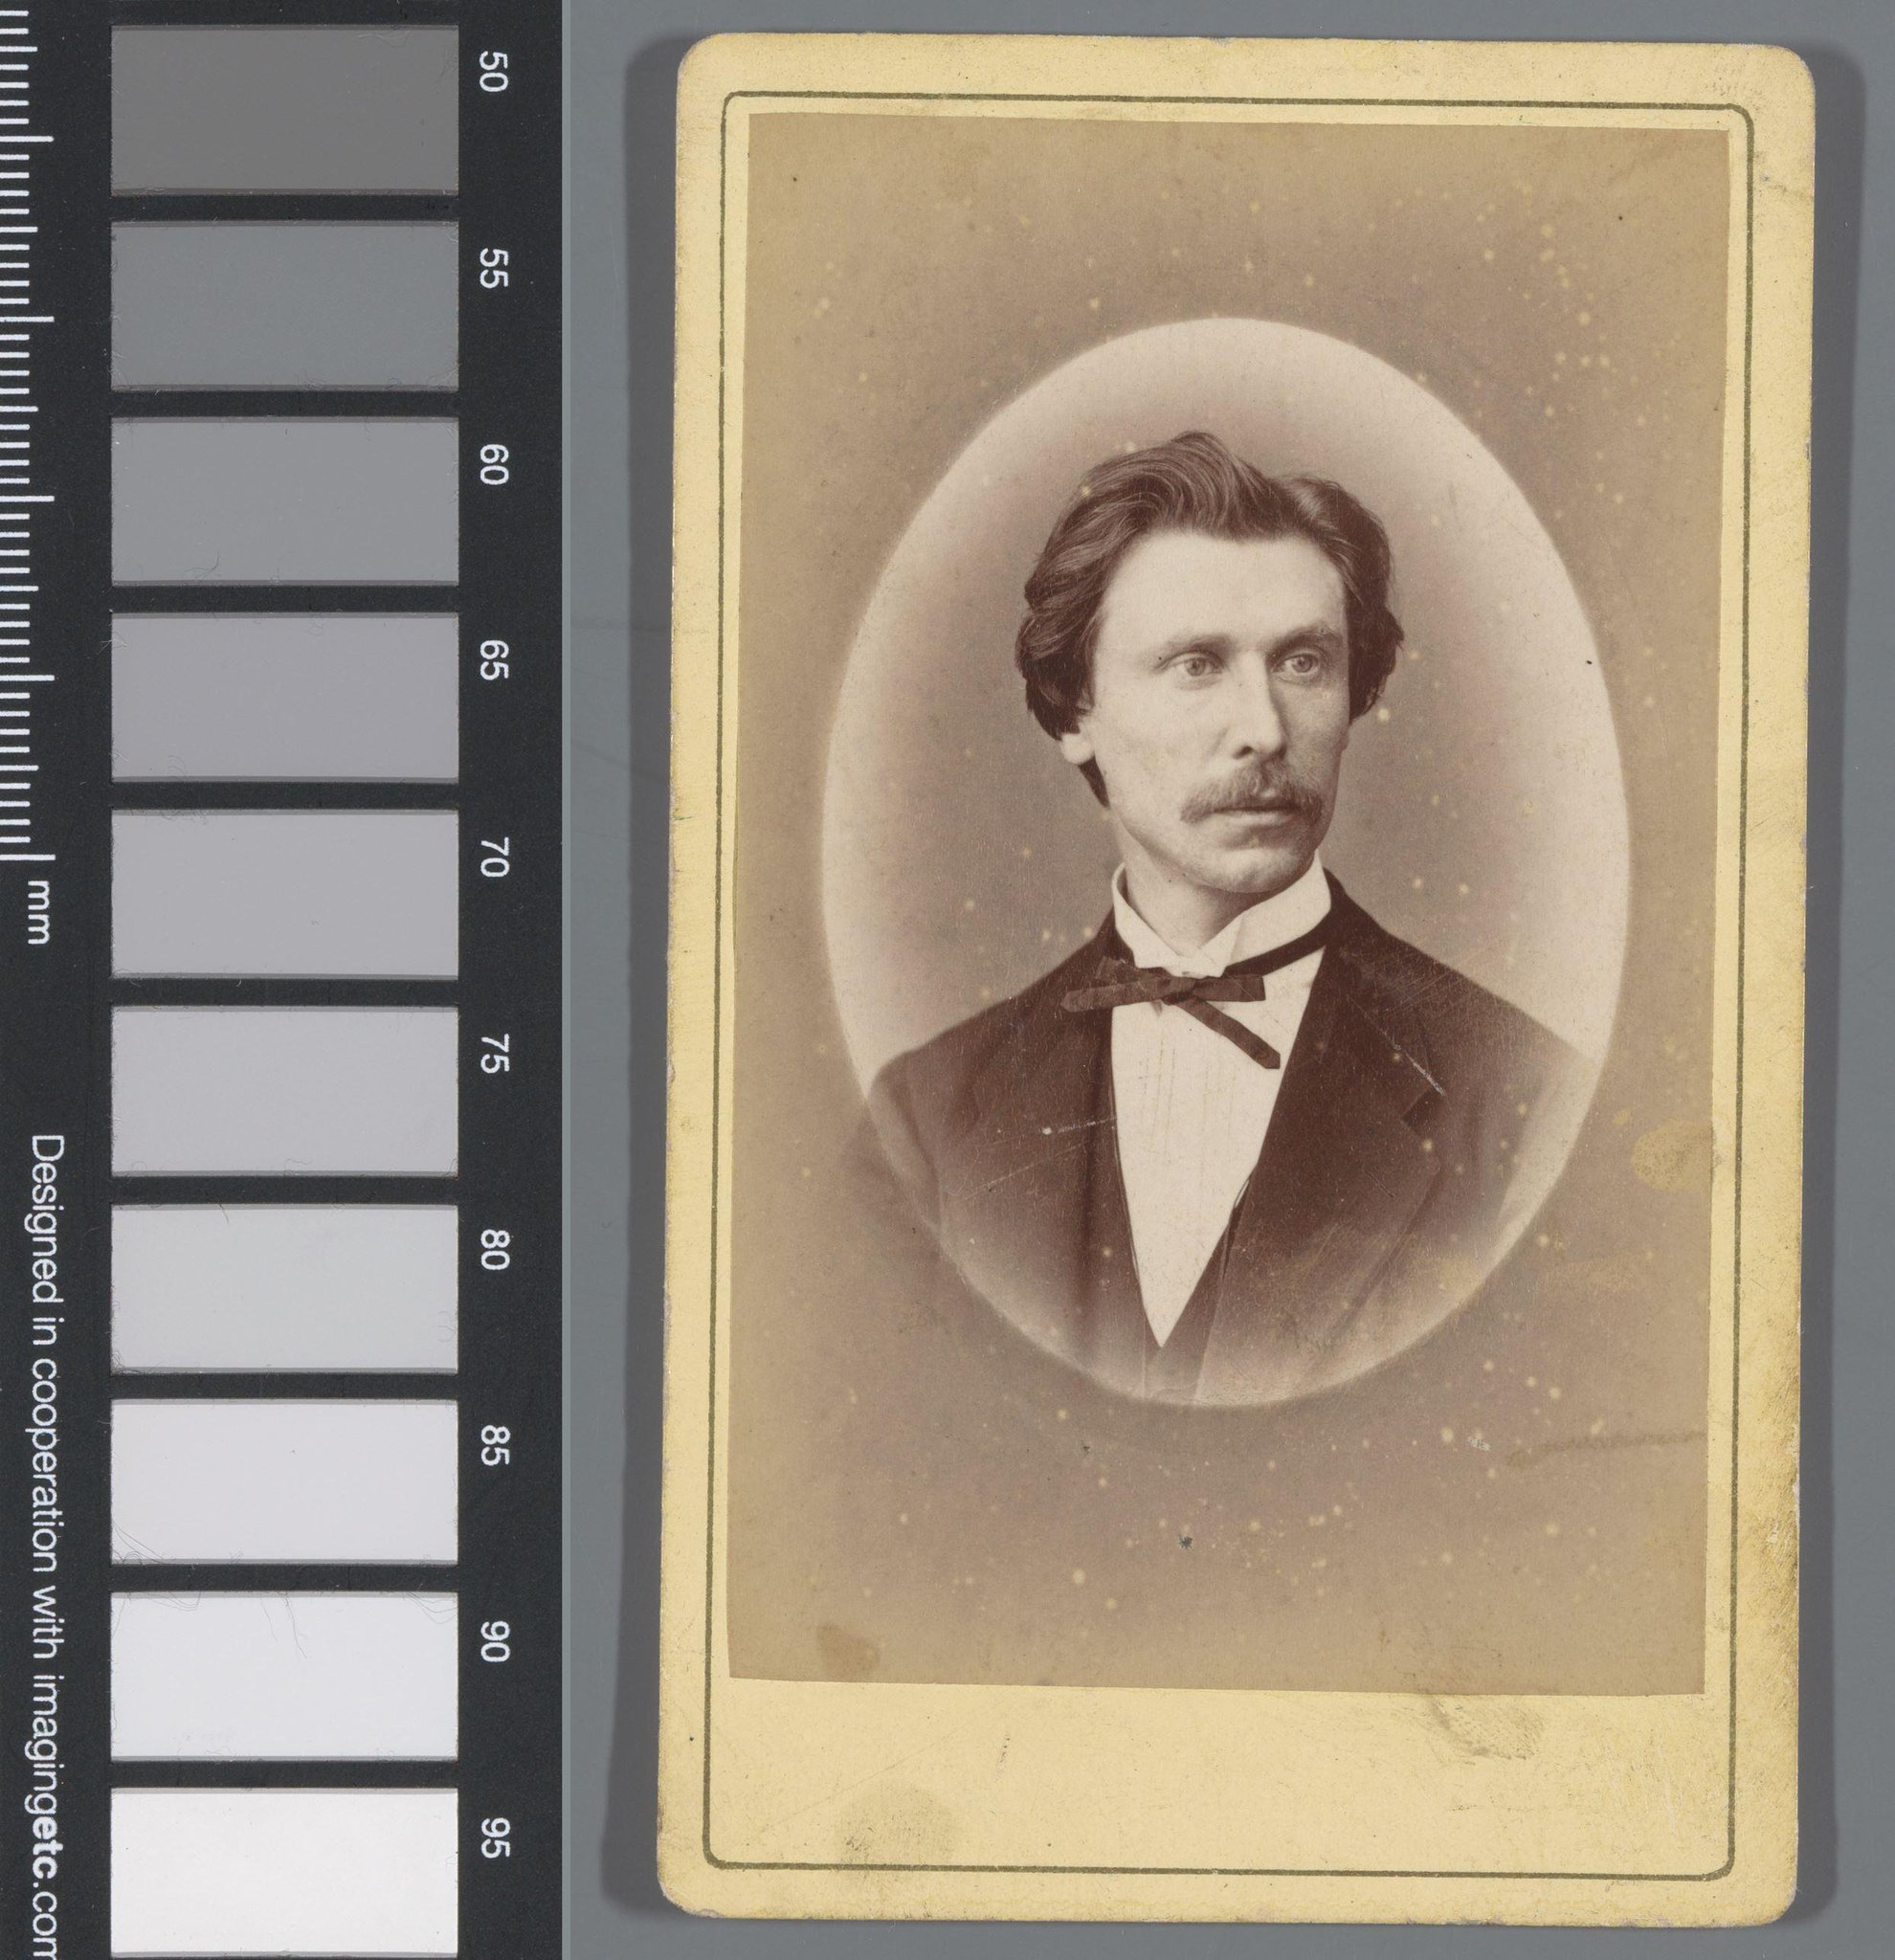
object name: photograph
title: Portret van een onbekende man met snor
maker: august rombaut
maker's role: fotograaf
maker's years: 1834-1892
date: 1867-1871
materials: cardboard, celluloid, paper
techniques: albumen print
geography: sint-niklaas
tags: adult man, anonymous historical person portrayed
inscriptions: address: ‘St NIKOLAAS, Nieuwstraat, 60.’